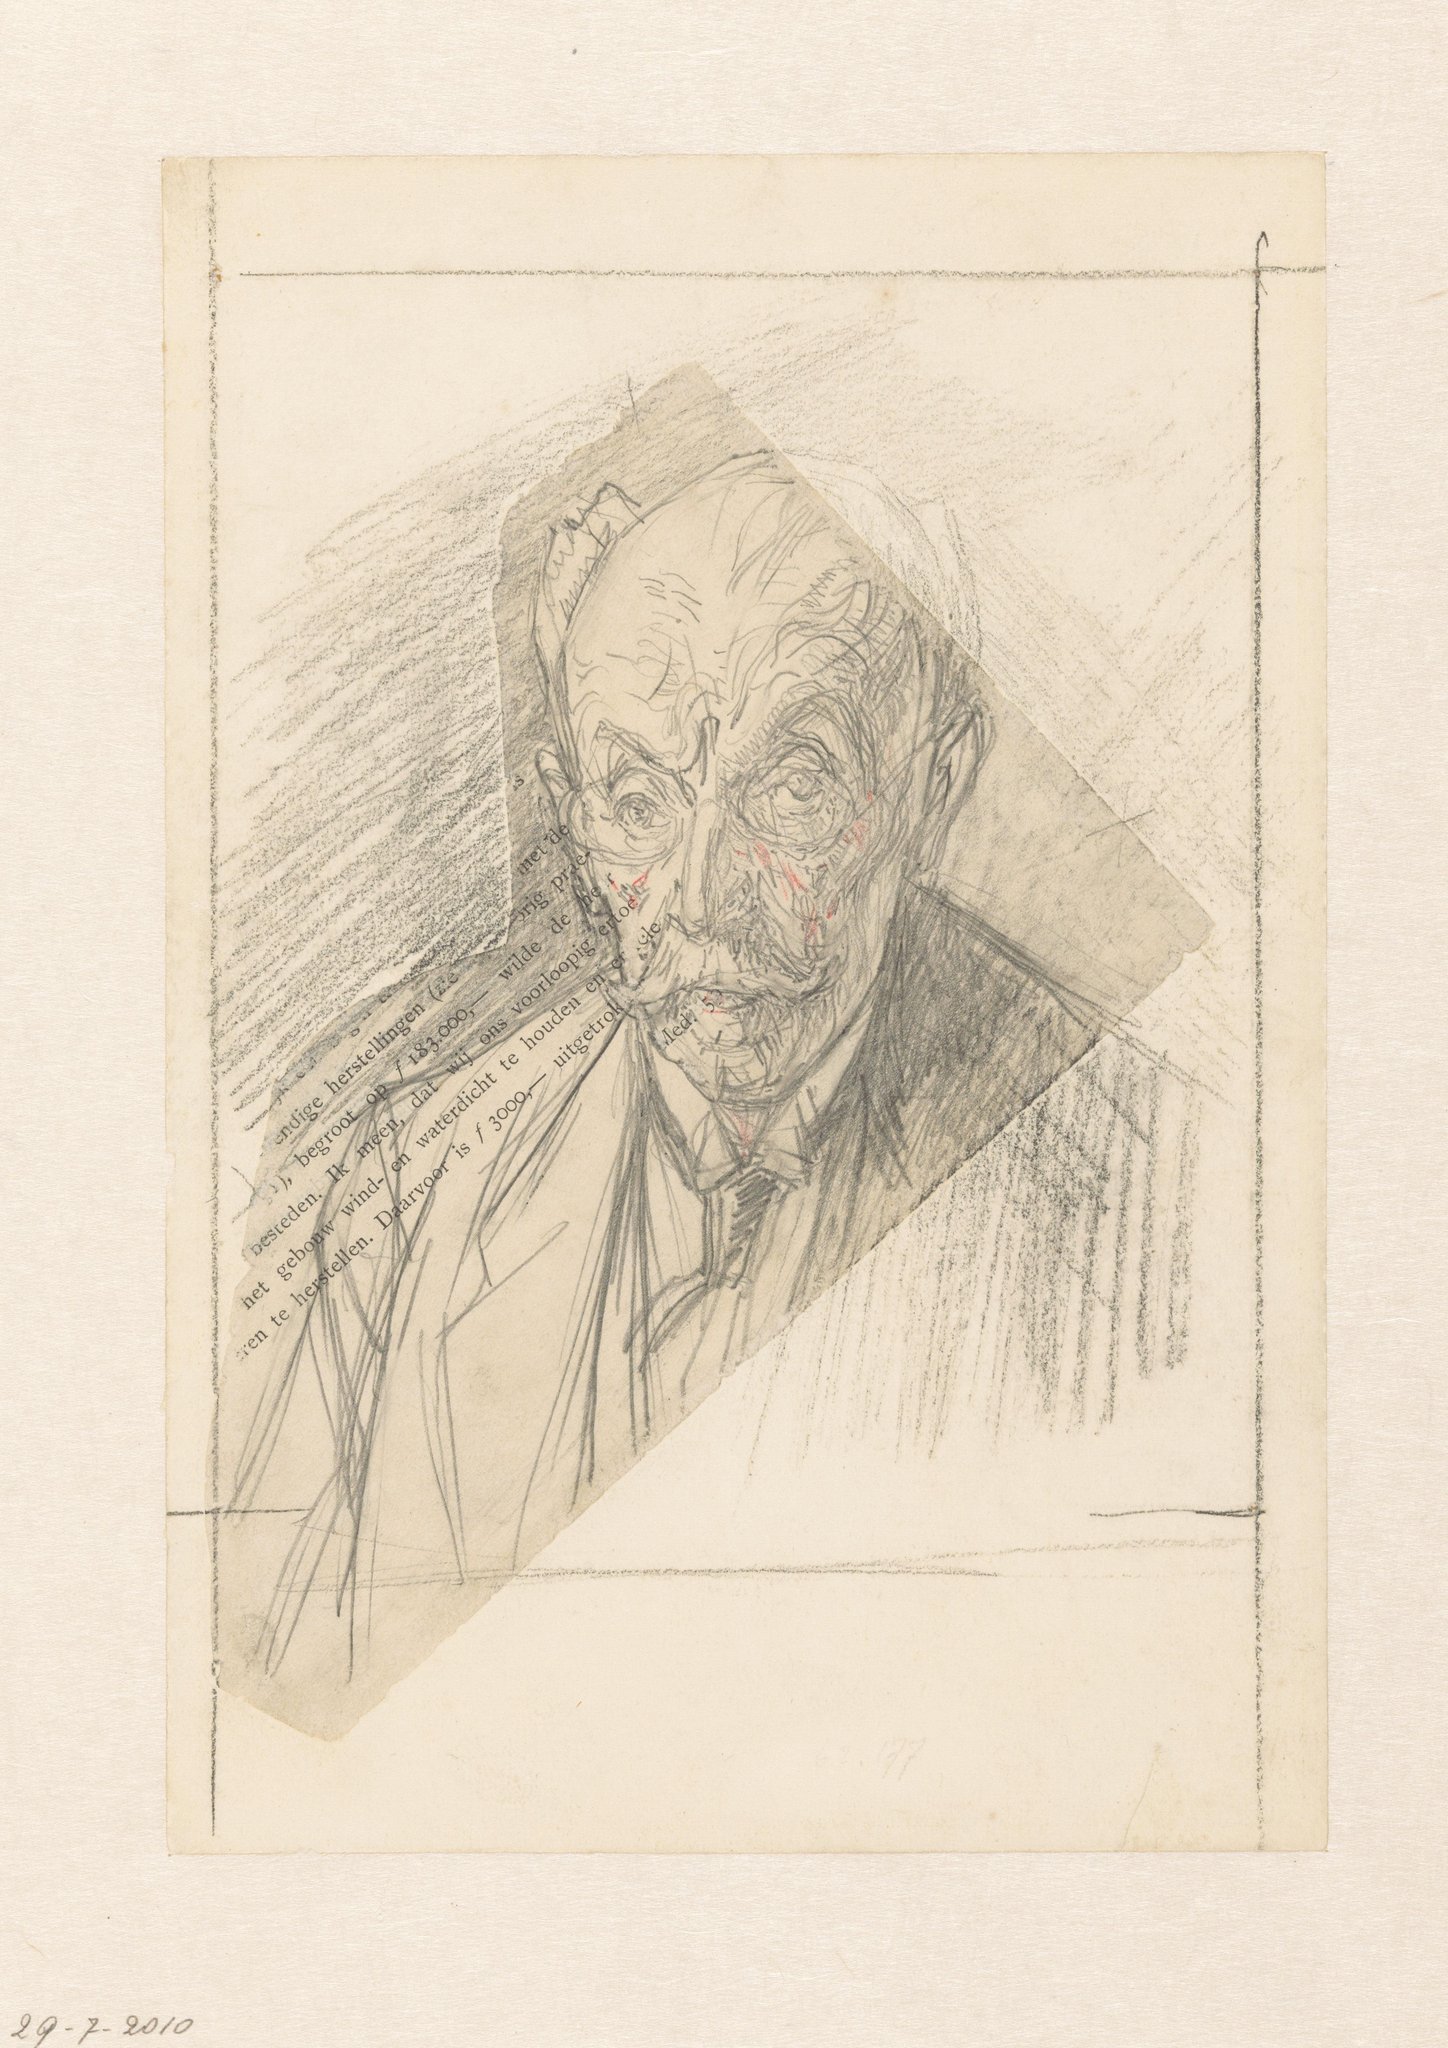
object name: drawing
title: Portret van een oudere man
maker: jan veth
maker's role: designer, draughtsman, painter, print maker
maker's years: 1864-1925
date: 1874-1925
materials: chalk, paper, pencil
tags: anonymous historical person portrayed alone